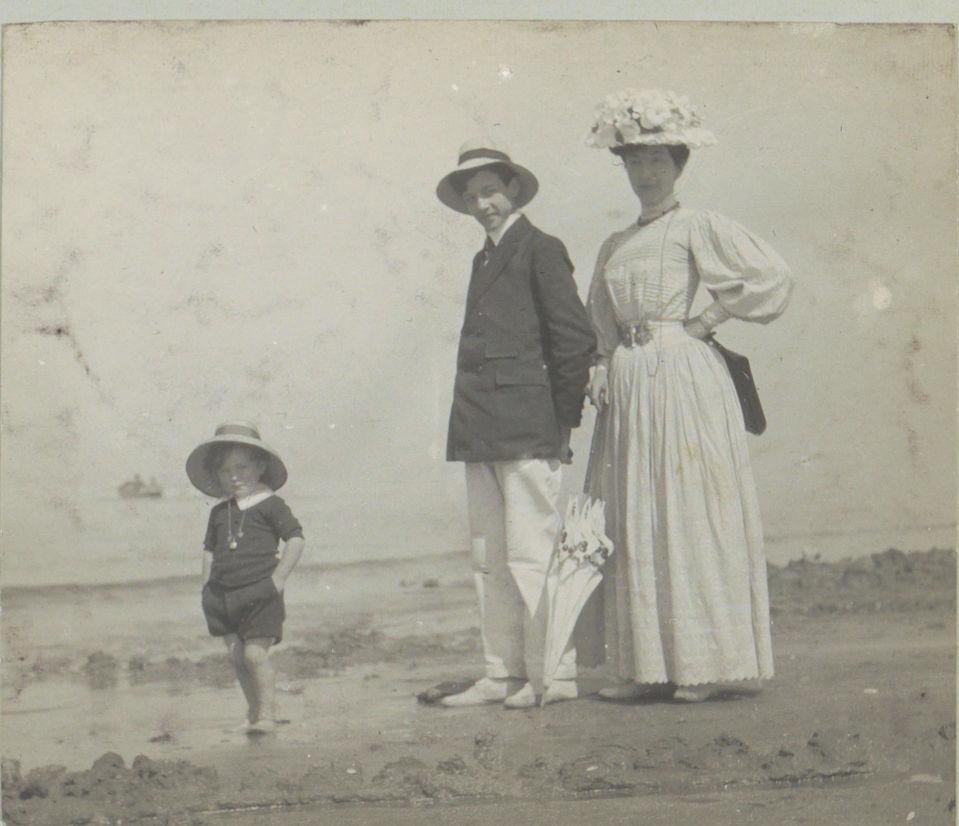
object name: photograph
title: Portret van een man, een vrouw en een kind aan het strand, vermoedelijk in Italië of Frankrijk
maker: Anonymous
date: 1905-1910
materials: paper, photographic support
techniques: matte daylight collodion silver print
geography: europe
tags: beach (as place of recreation), family group, especially parents with their child(ren), dress, gown, europe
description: Onderdeel van Fotoalbum van een Franse amateurfotograaf met bezienswaardigheden in Frankrijk, Zwitserland en Italië.